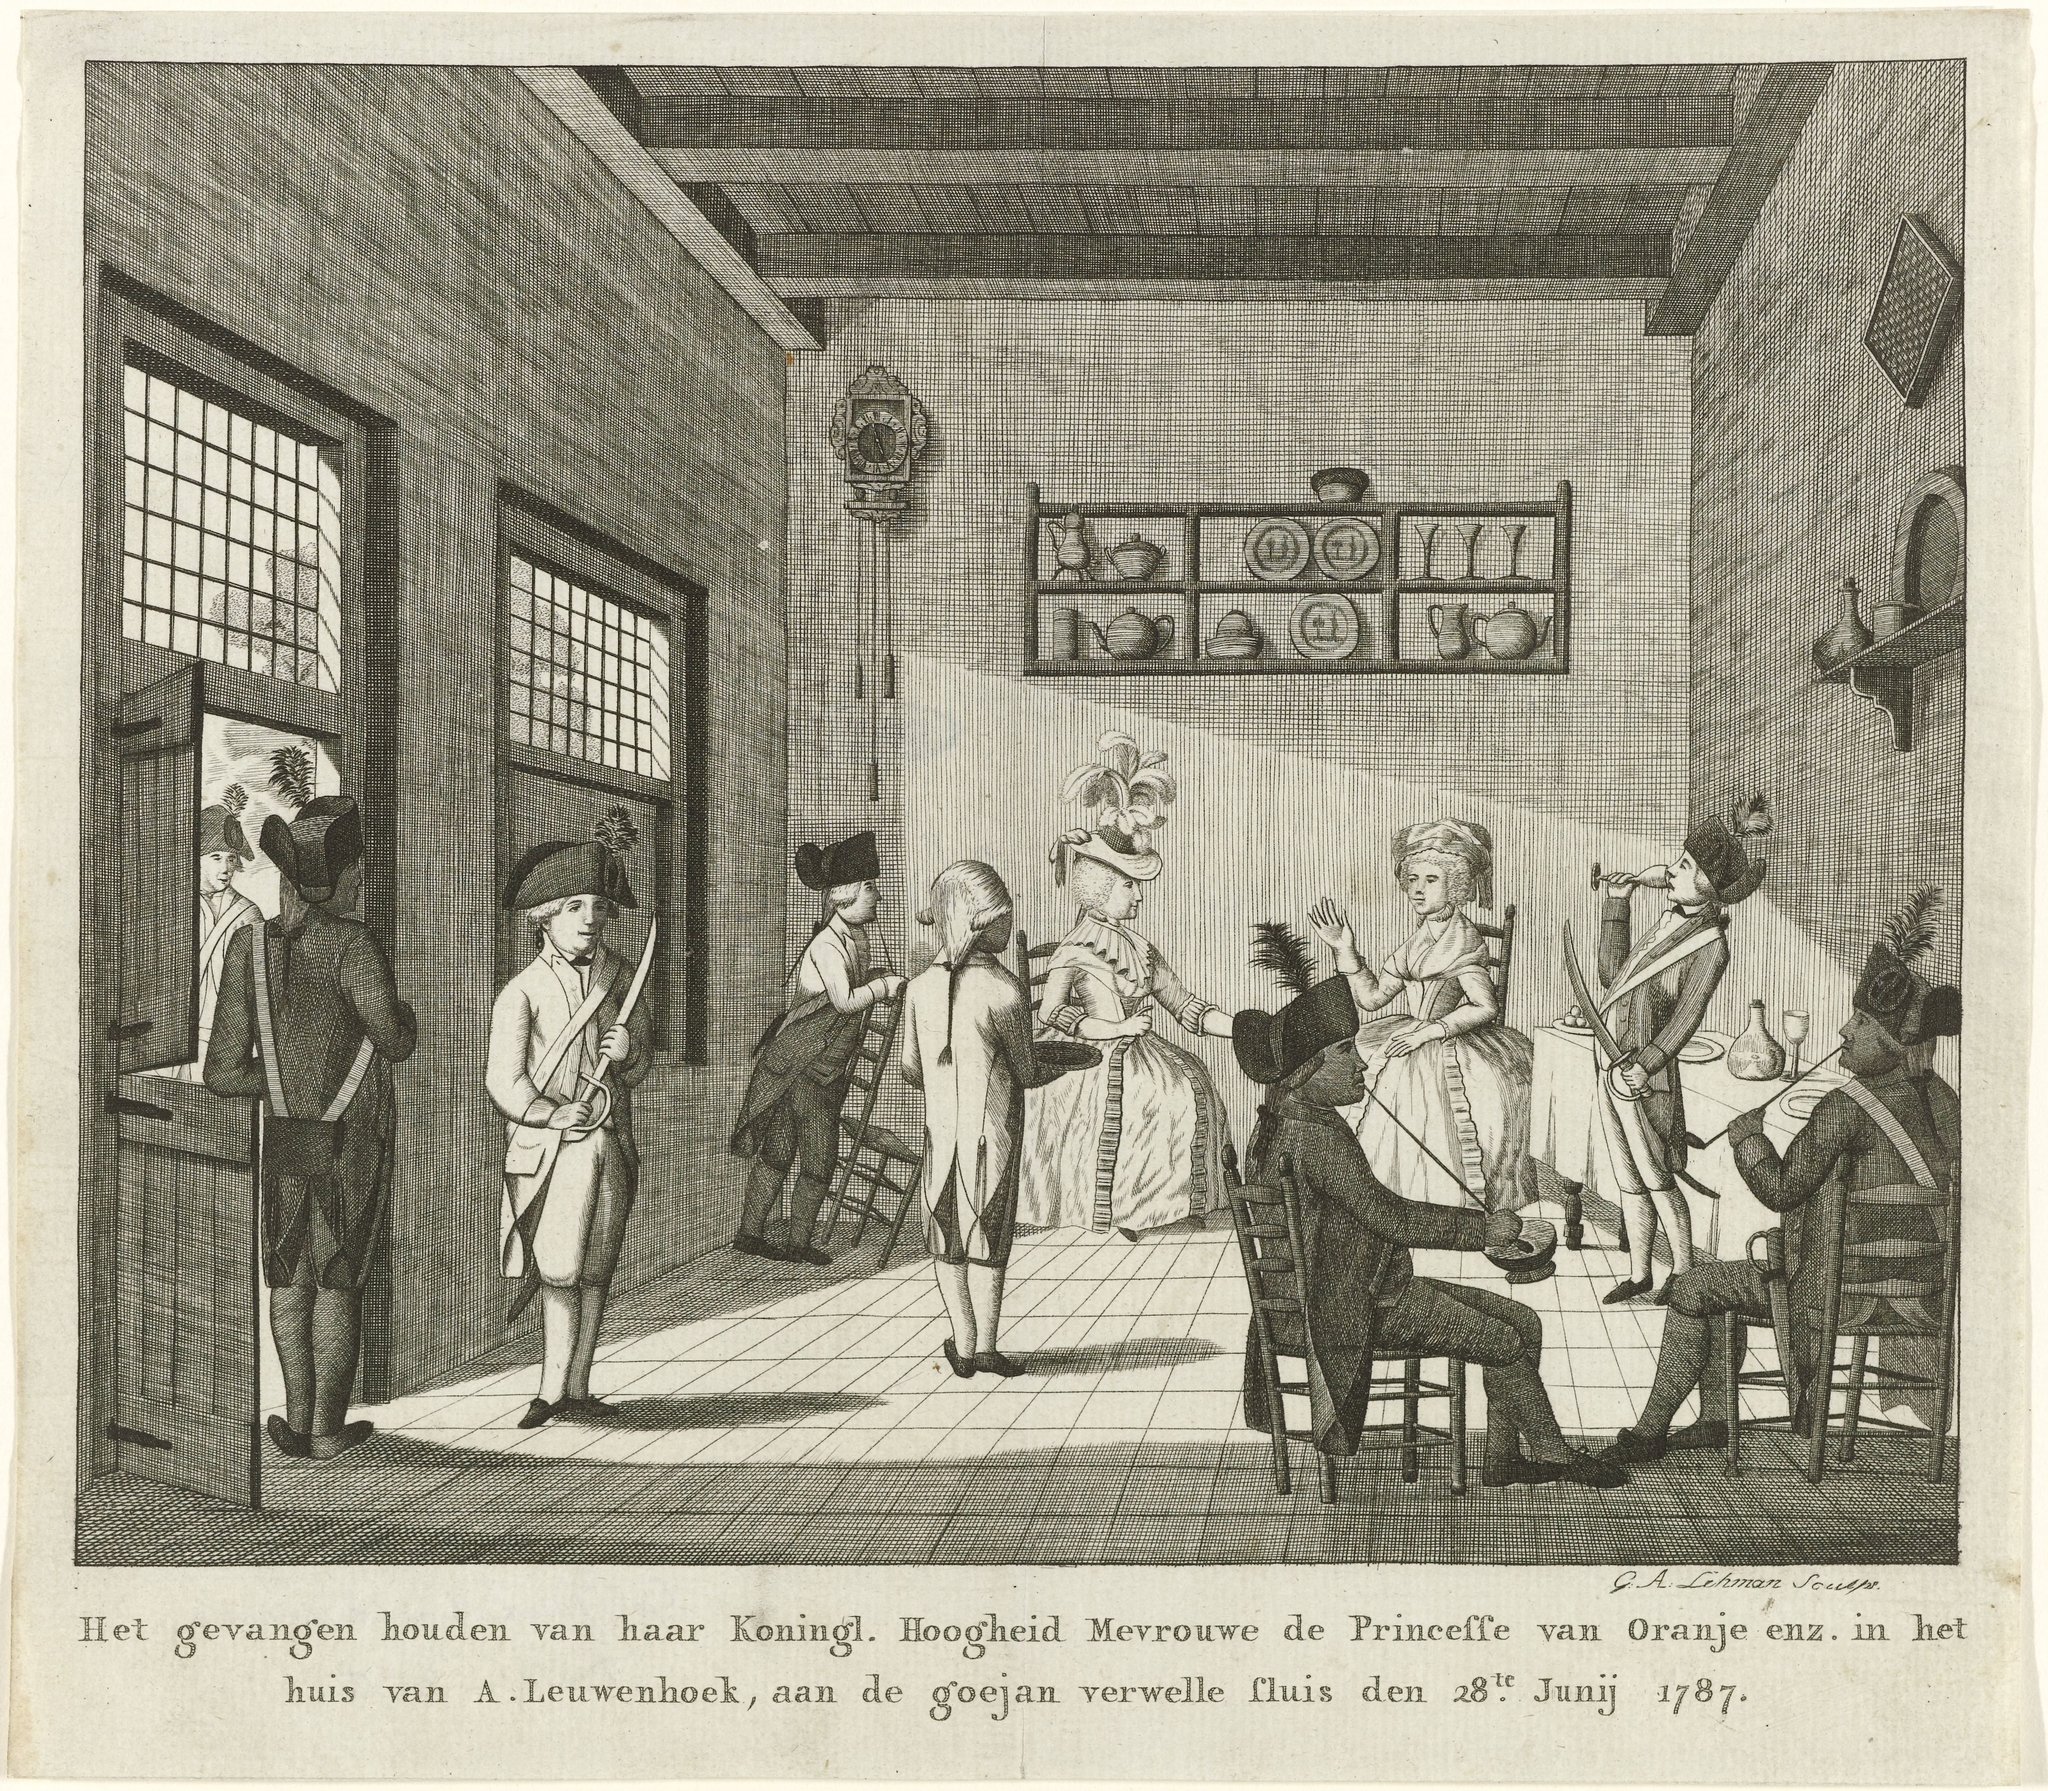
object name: print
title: Prinses van Oranje aangehouden te Goejanverwellesluis, 1787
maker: gottfried arnold lehman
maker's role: print maker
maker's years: 1770-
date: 1787-1791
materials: paper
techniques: engraving, etching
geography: northern netherlands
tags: berlin, painter, draughtsman, wilhelmina of prussia (princess of orange), arrest (of criminal)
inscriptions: collector's mark: Lugt 2228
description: Gebruikt als illustratie in: Monument voor Amsterdam in drie zangen. Dl. 2: Het groot toneel van verwarringen, in Amsterdam en elders vertoond, in de zomer des jaars 1787. Amsterdam: J. Peppelenbos, 1791.